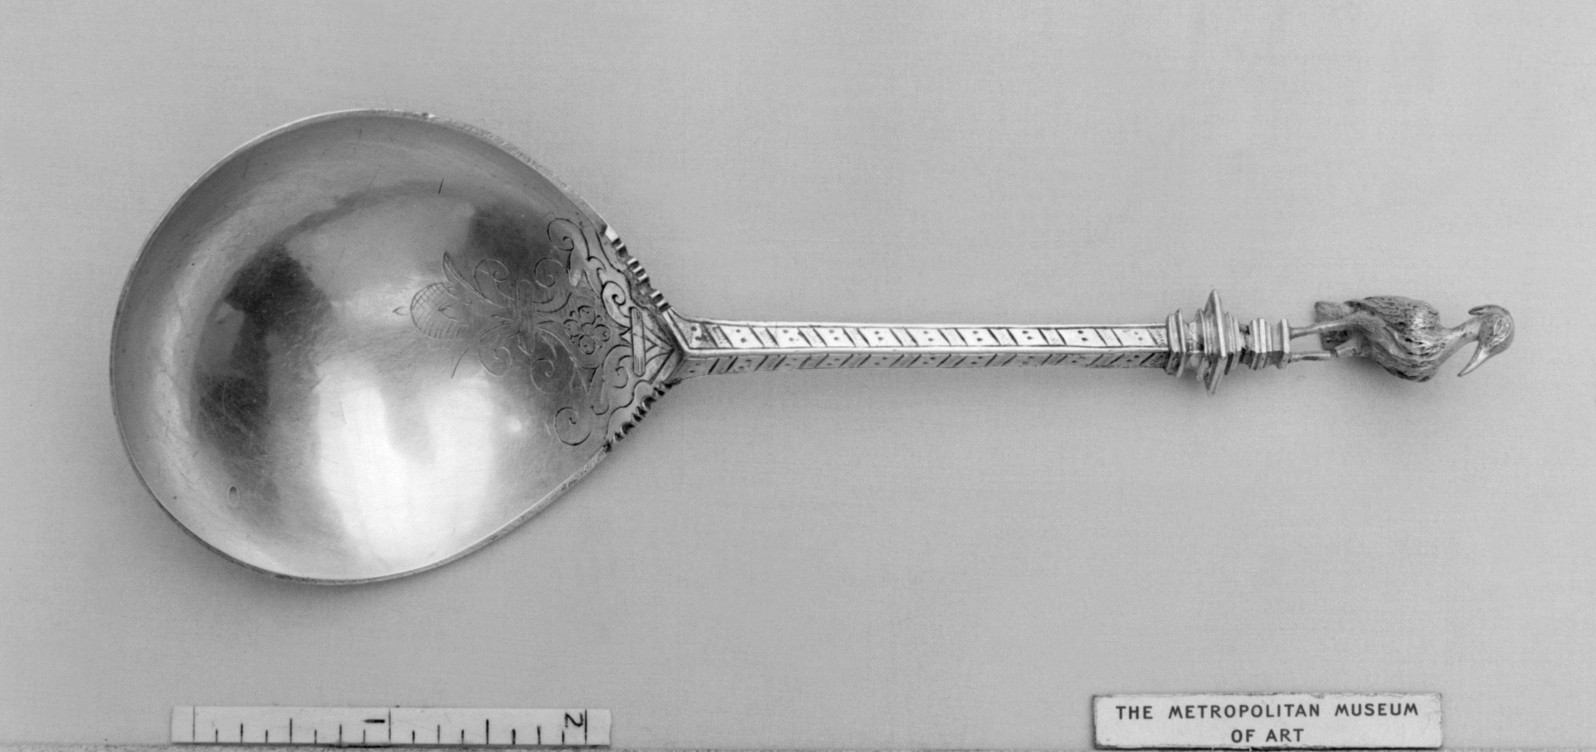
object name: spoon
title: Figure-top spoon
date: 1601-1625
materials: silver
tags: birds